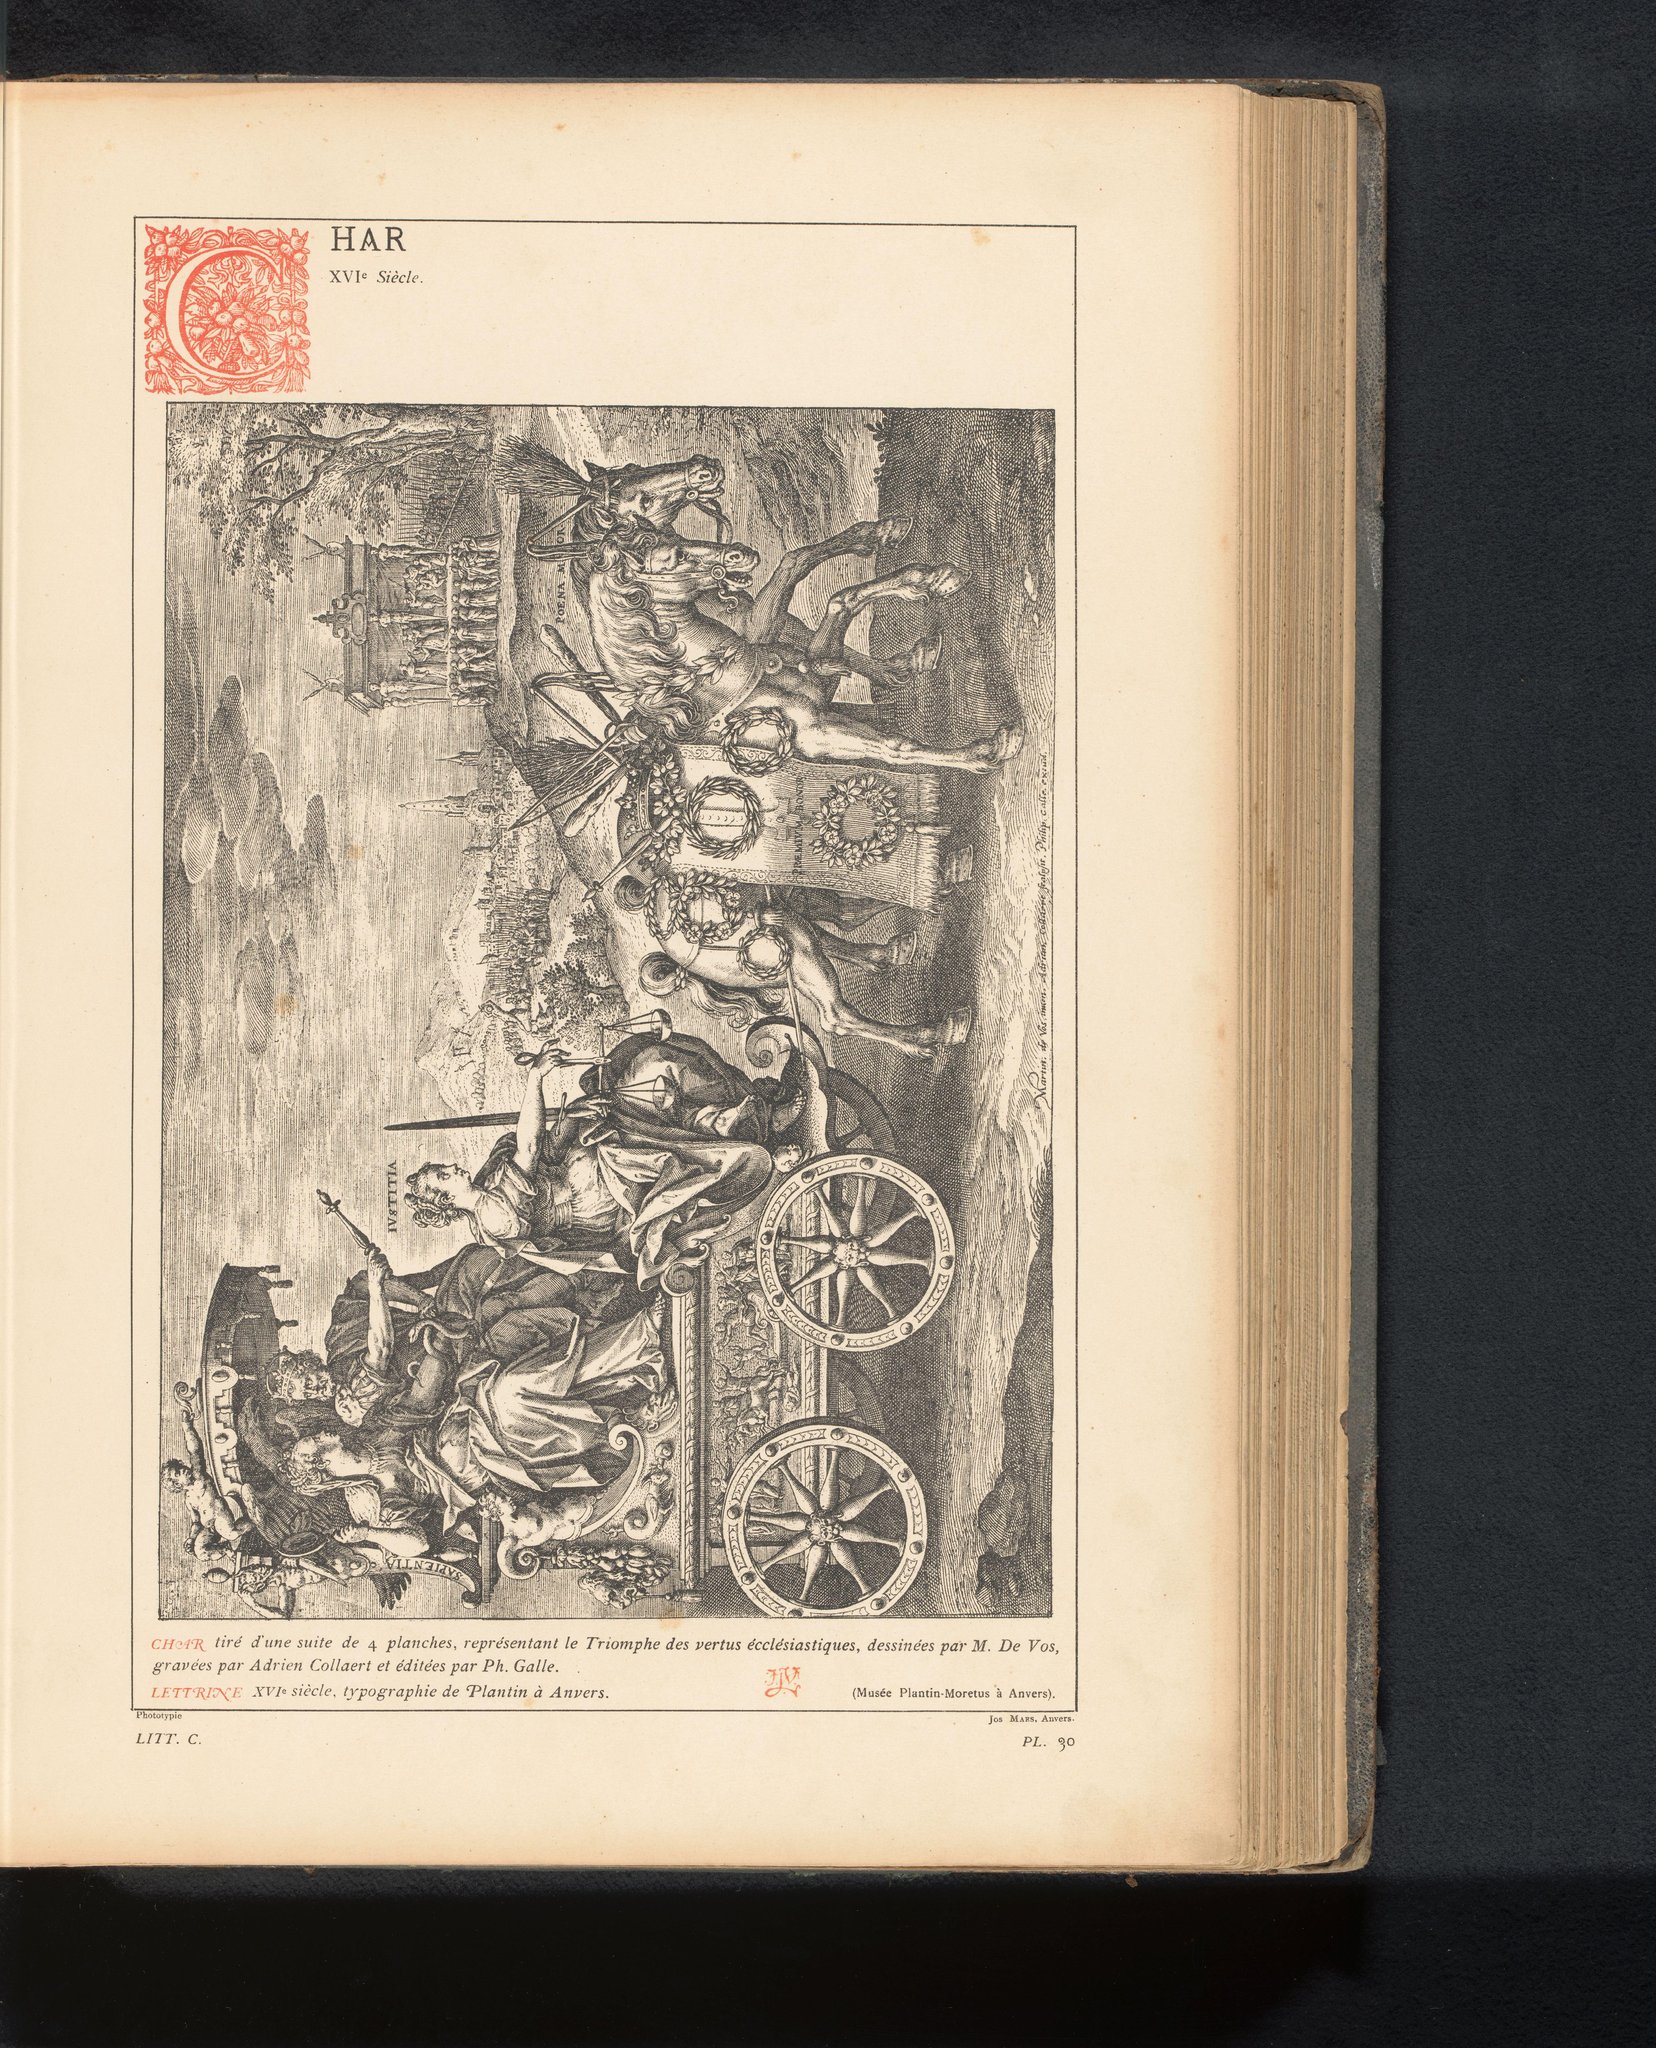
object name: photomechanical print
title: Char, XVIIIe Siècle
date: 1875-1880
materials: paper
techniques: photolithography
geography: antwerp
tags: chariot, triumphal car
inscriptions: monogram: ‘JJvY’, inscription: ‘Char tiré d'une (...)’, inscription: ‘LITT: C. - PL. 30’